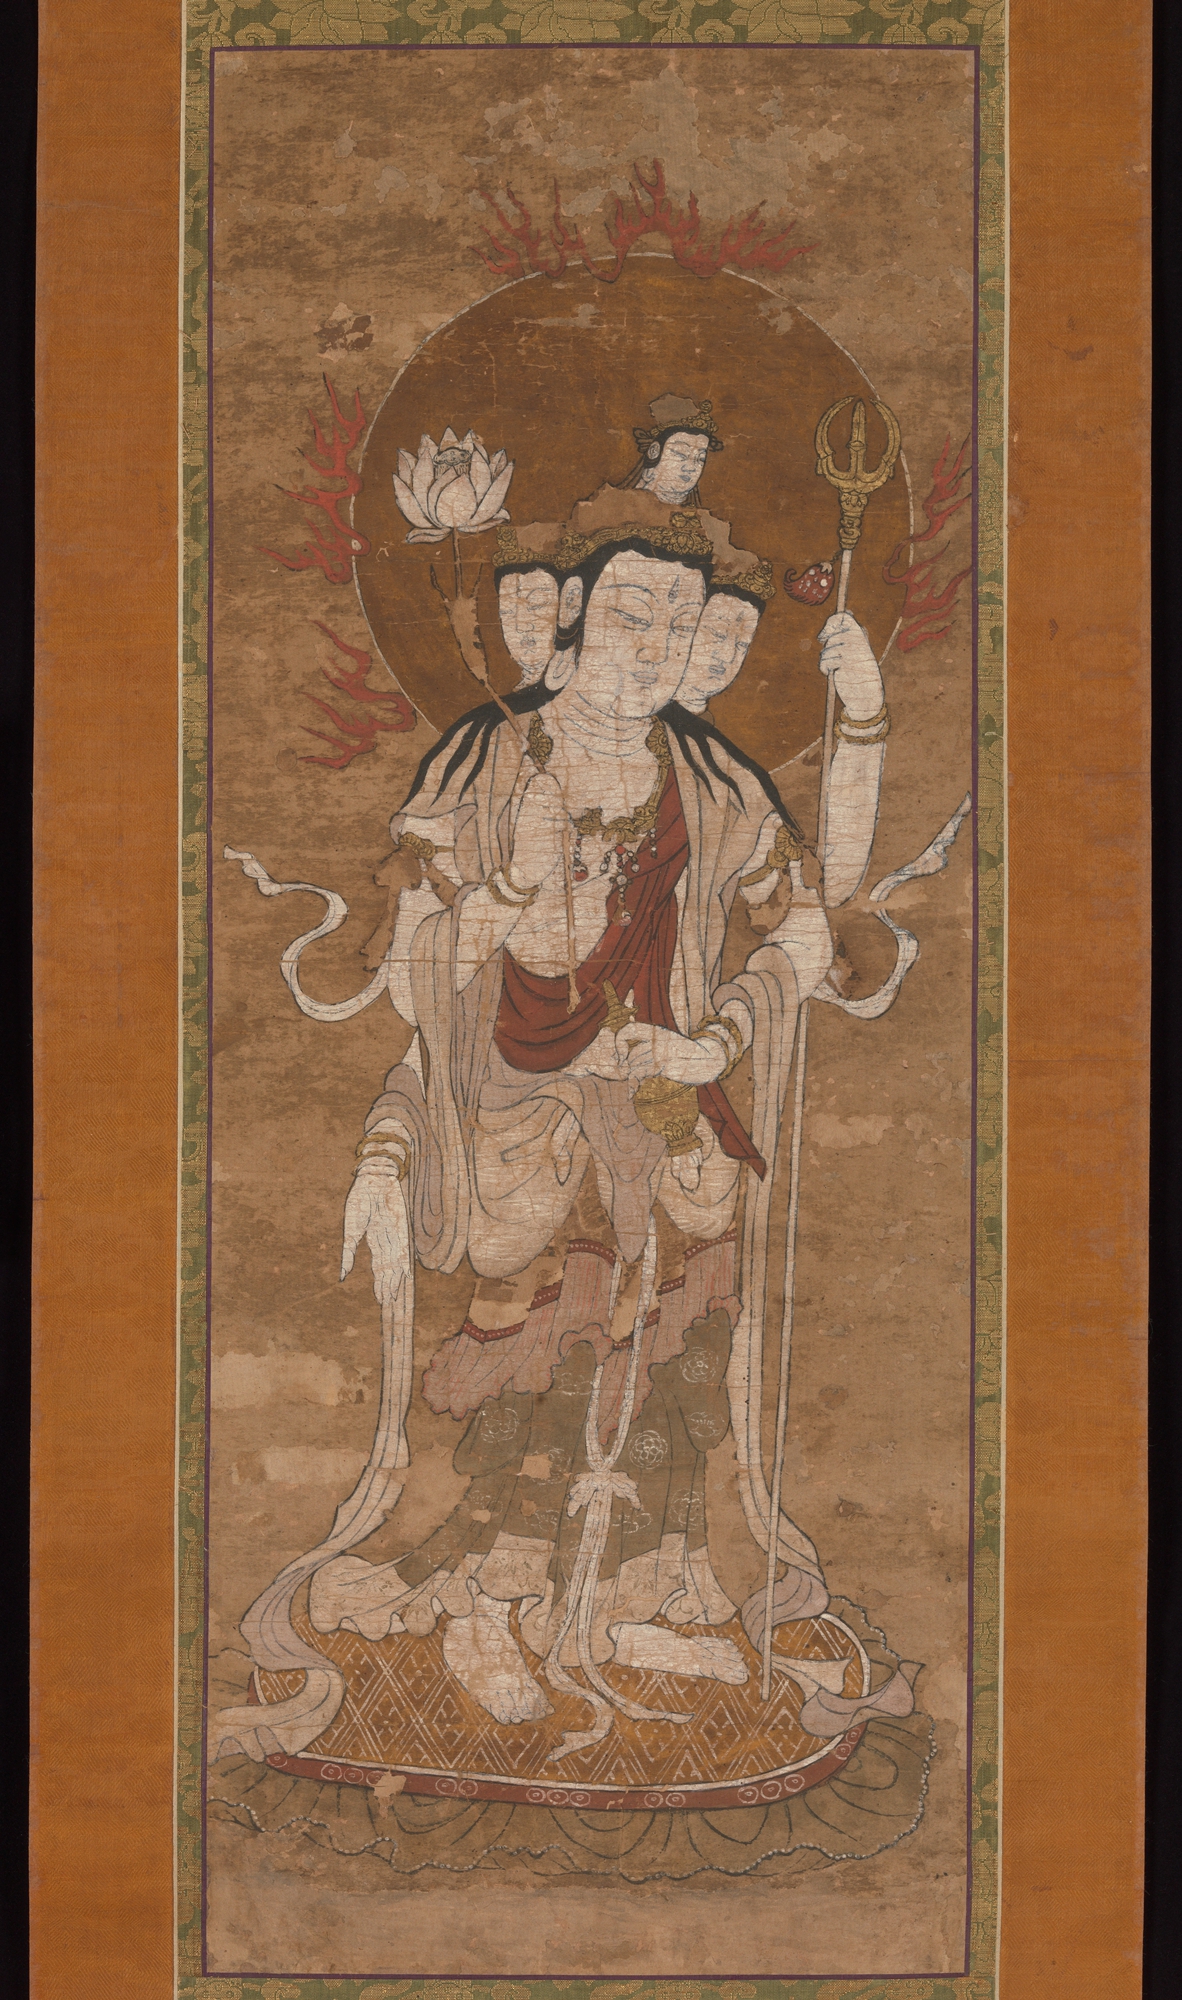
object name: hanging scroll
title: One of the Twelve Celestial Guardians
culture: japanese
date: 1301-1400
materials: paper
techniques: hand coloring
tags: buddhism,deities